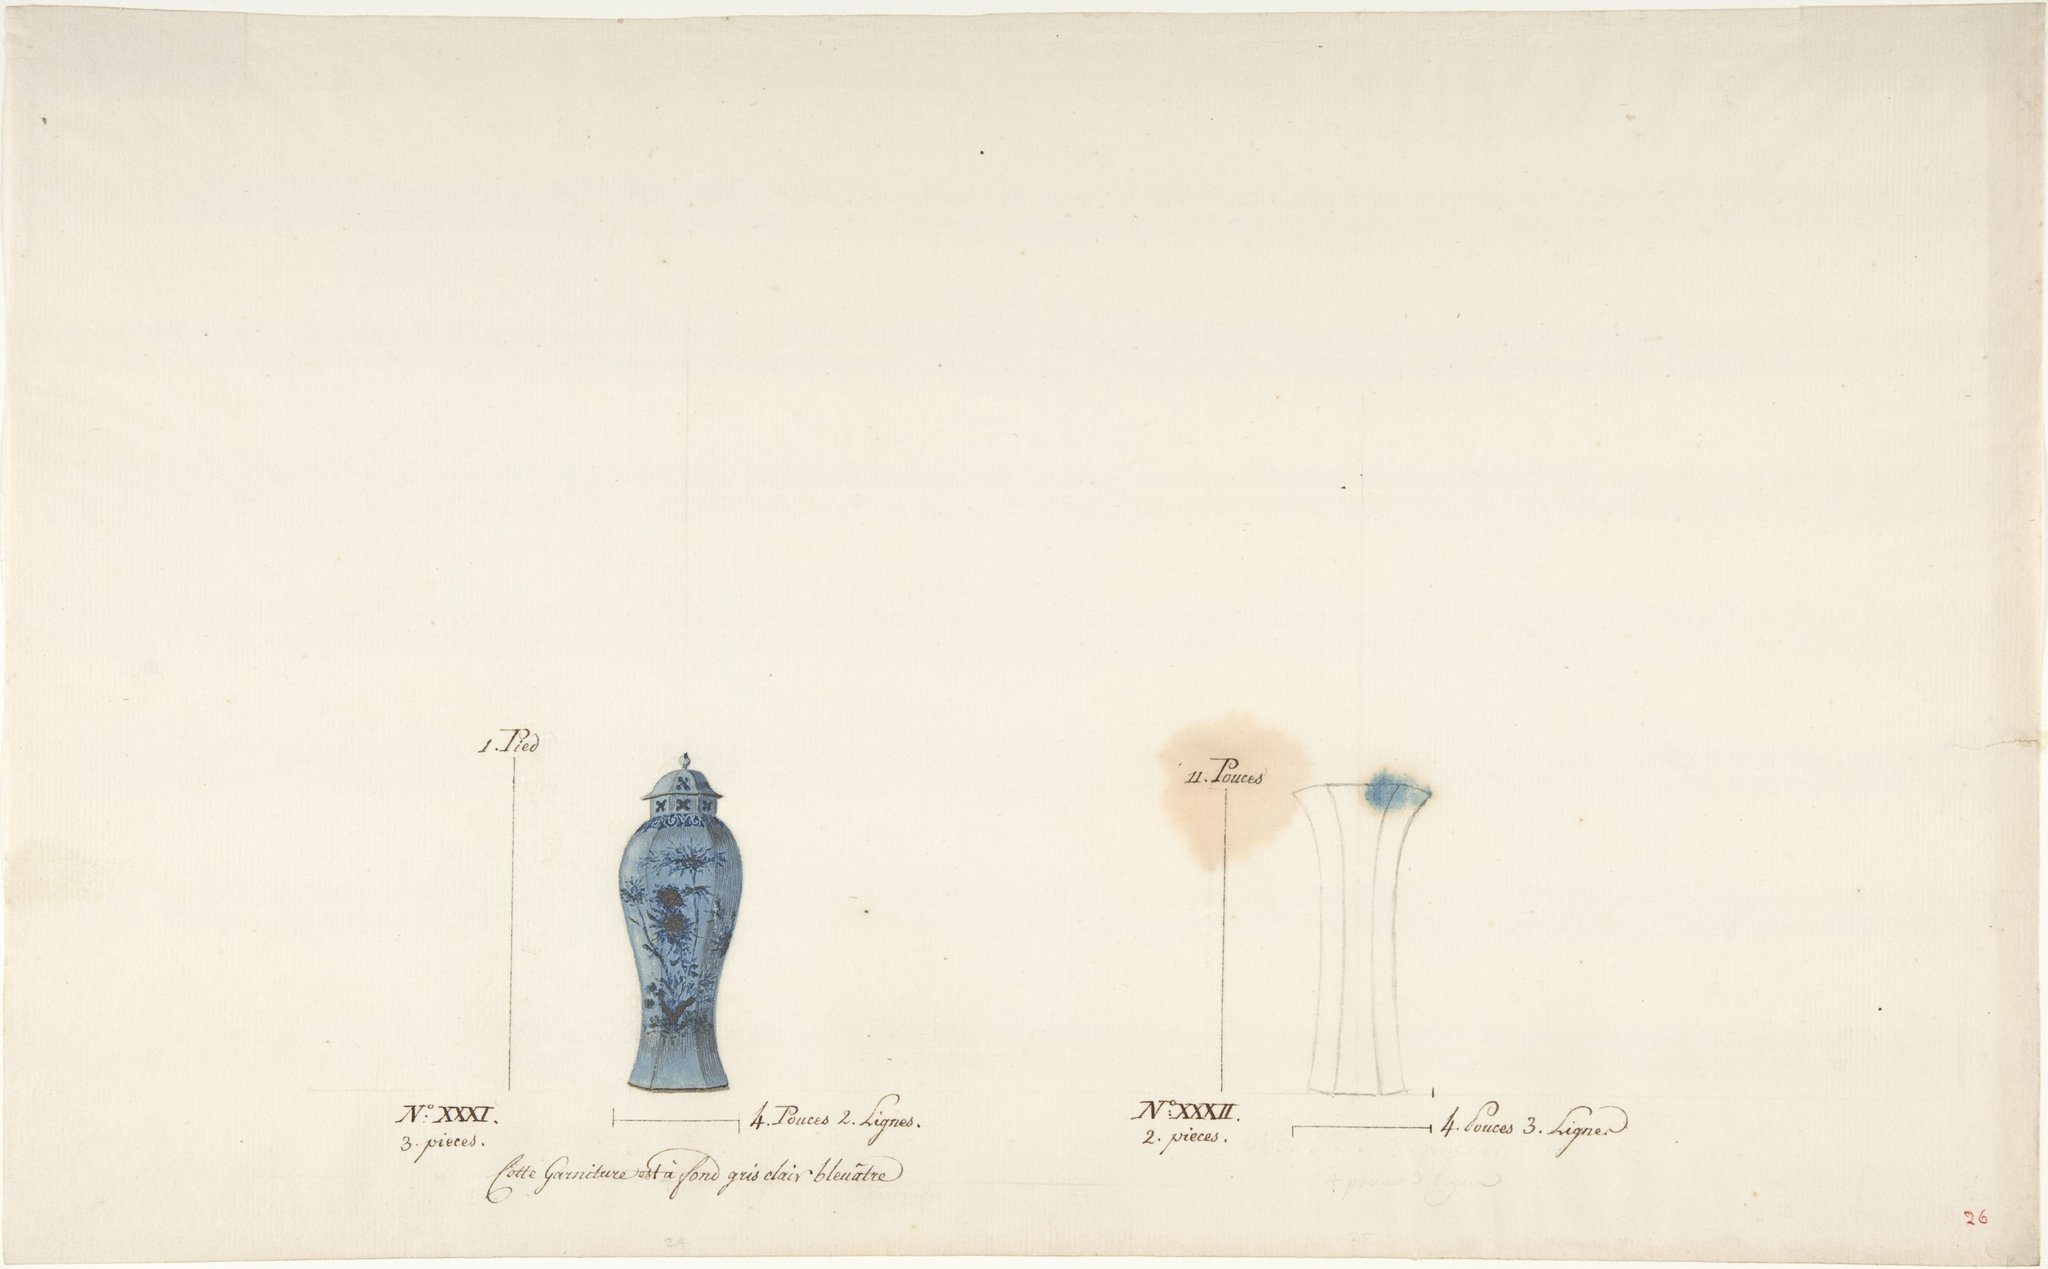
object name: drawing ornament architecture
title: Design for Two Vases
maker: anonymous, french, 18th century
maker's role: artist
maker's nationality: french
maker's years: 1700-1800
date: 1770-1785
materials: chalk, ink, watercolor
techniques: pen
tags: flowers,leaves,vases